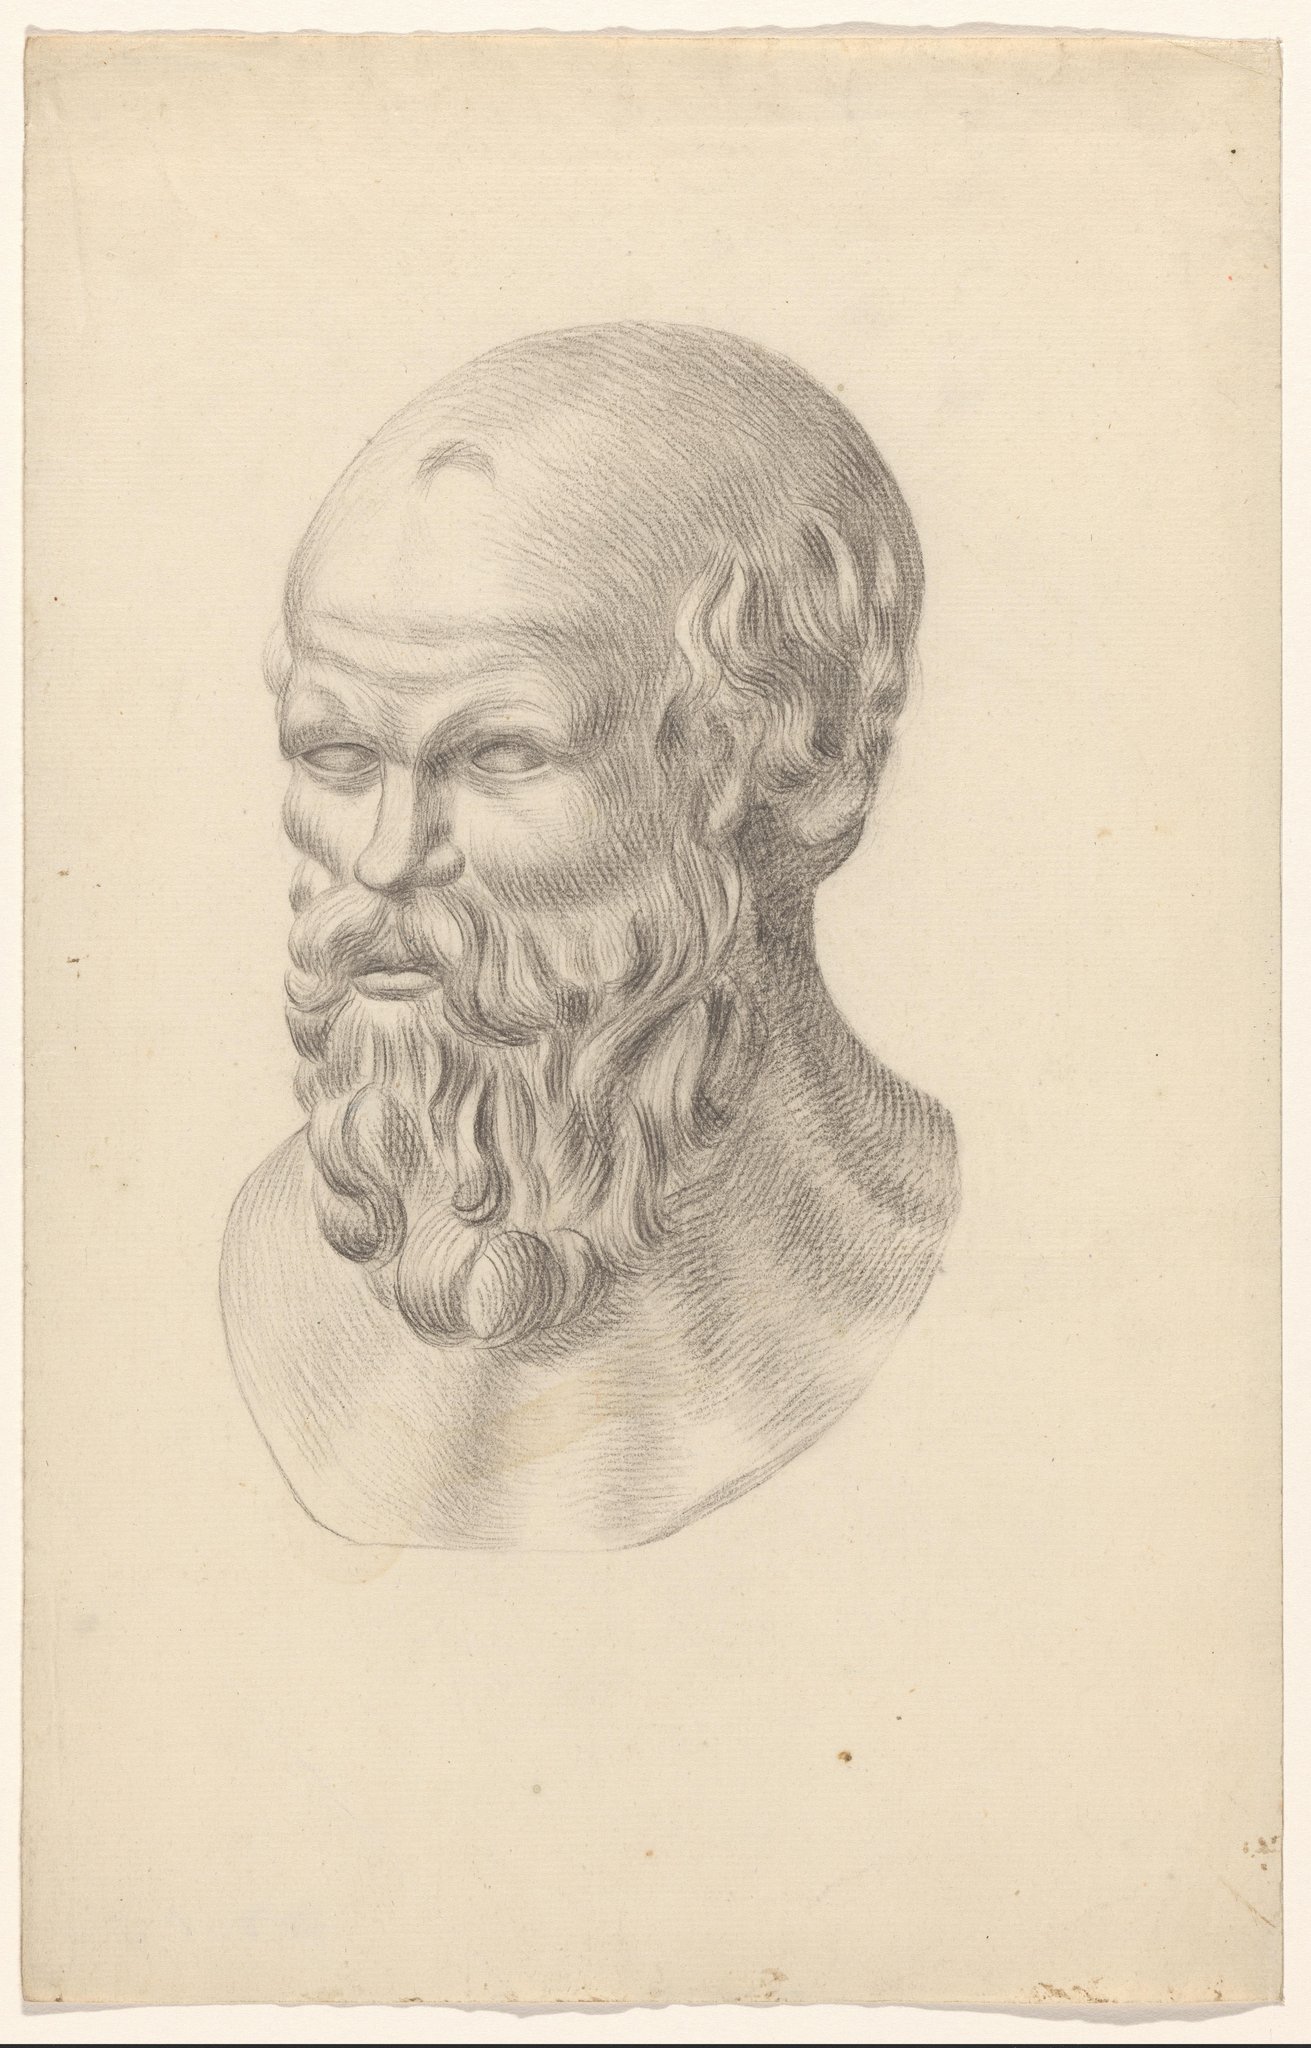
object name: drawing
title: Studie van een buste van een oude man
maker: joannes carolus alberdingk thijm (jan)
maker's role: pater, schrijver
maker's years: 1847-1926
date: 1853-1860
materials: chalk, paper, pencil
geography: netherlands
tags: old man, sculpture, classical antiquity (historical epoch)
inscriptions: inscription: ‘N8. C.S.’